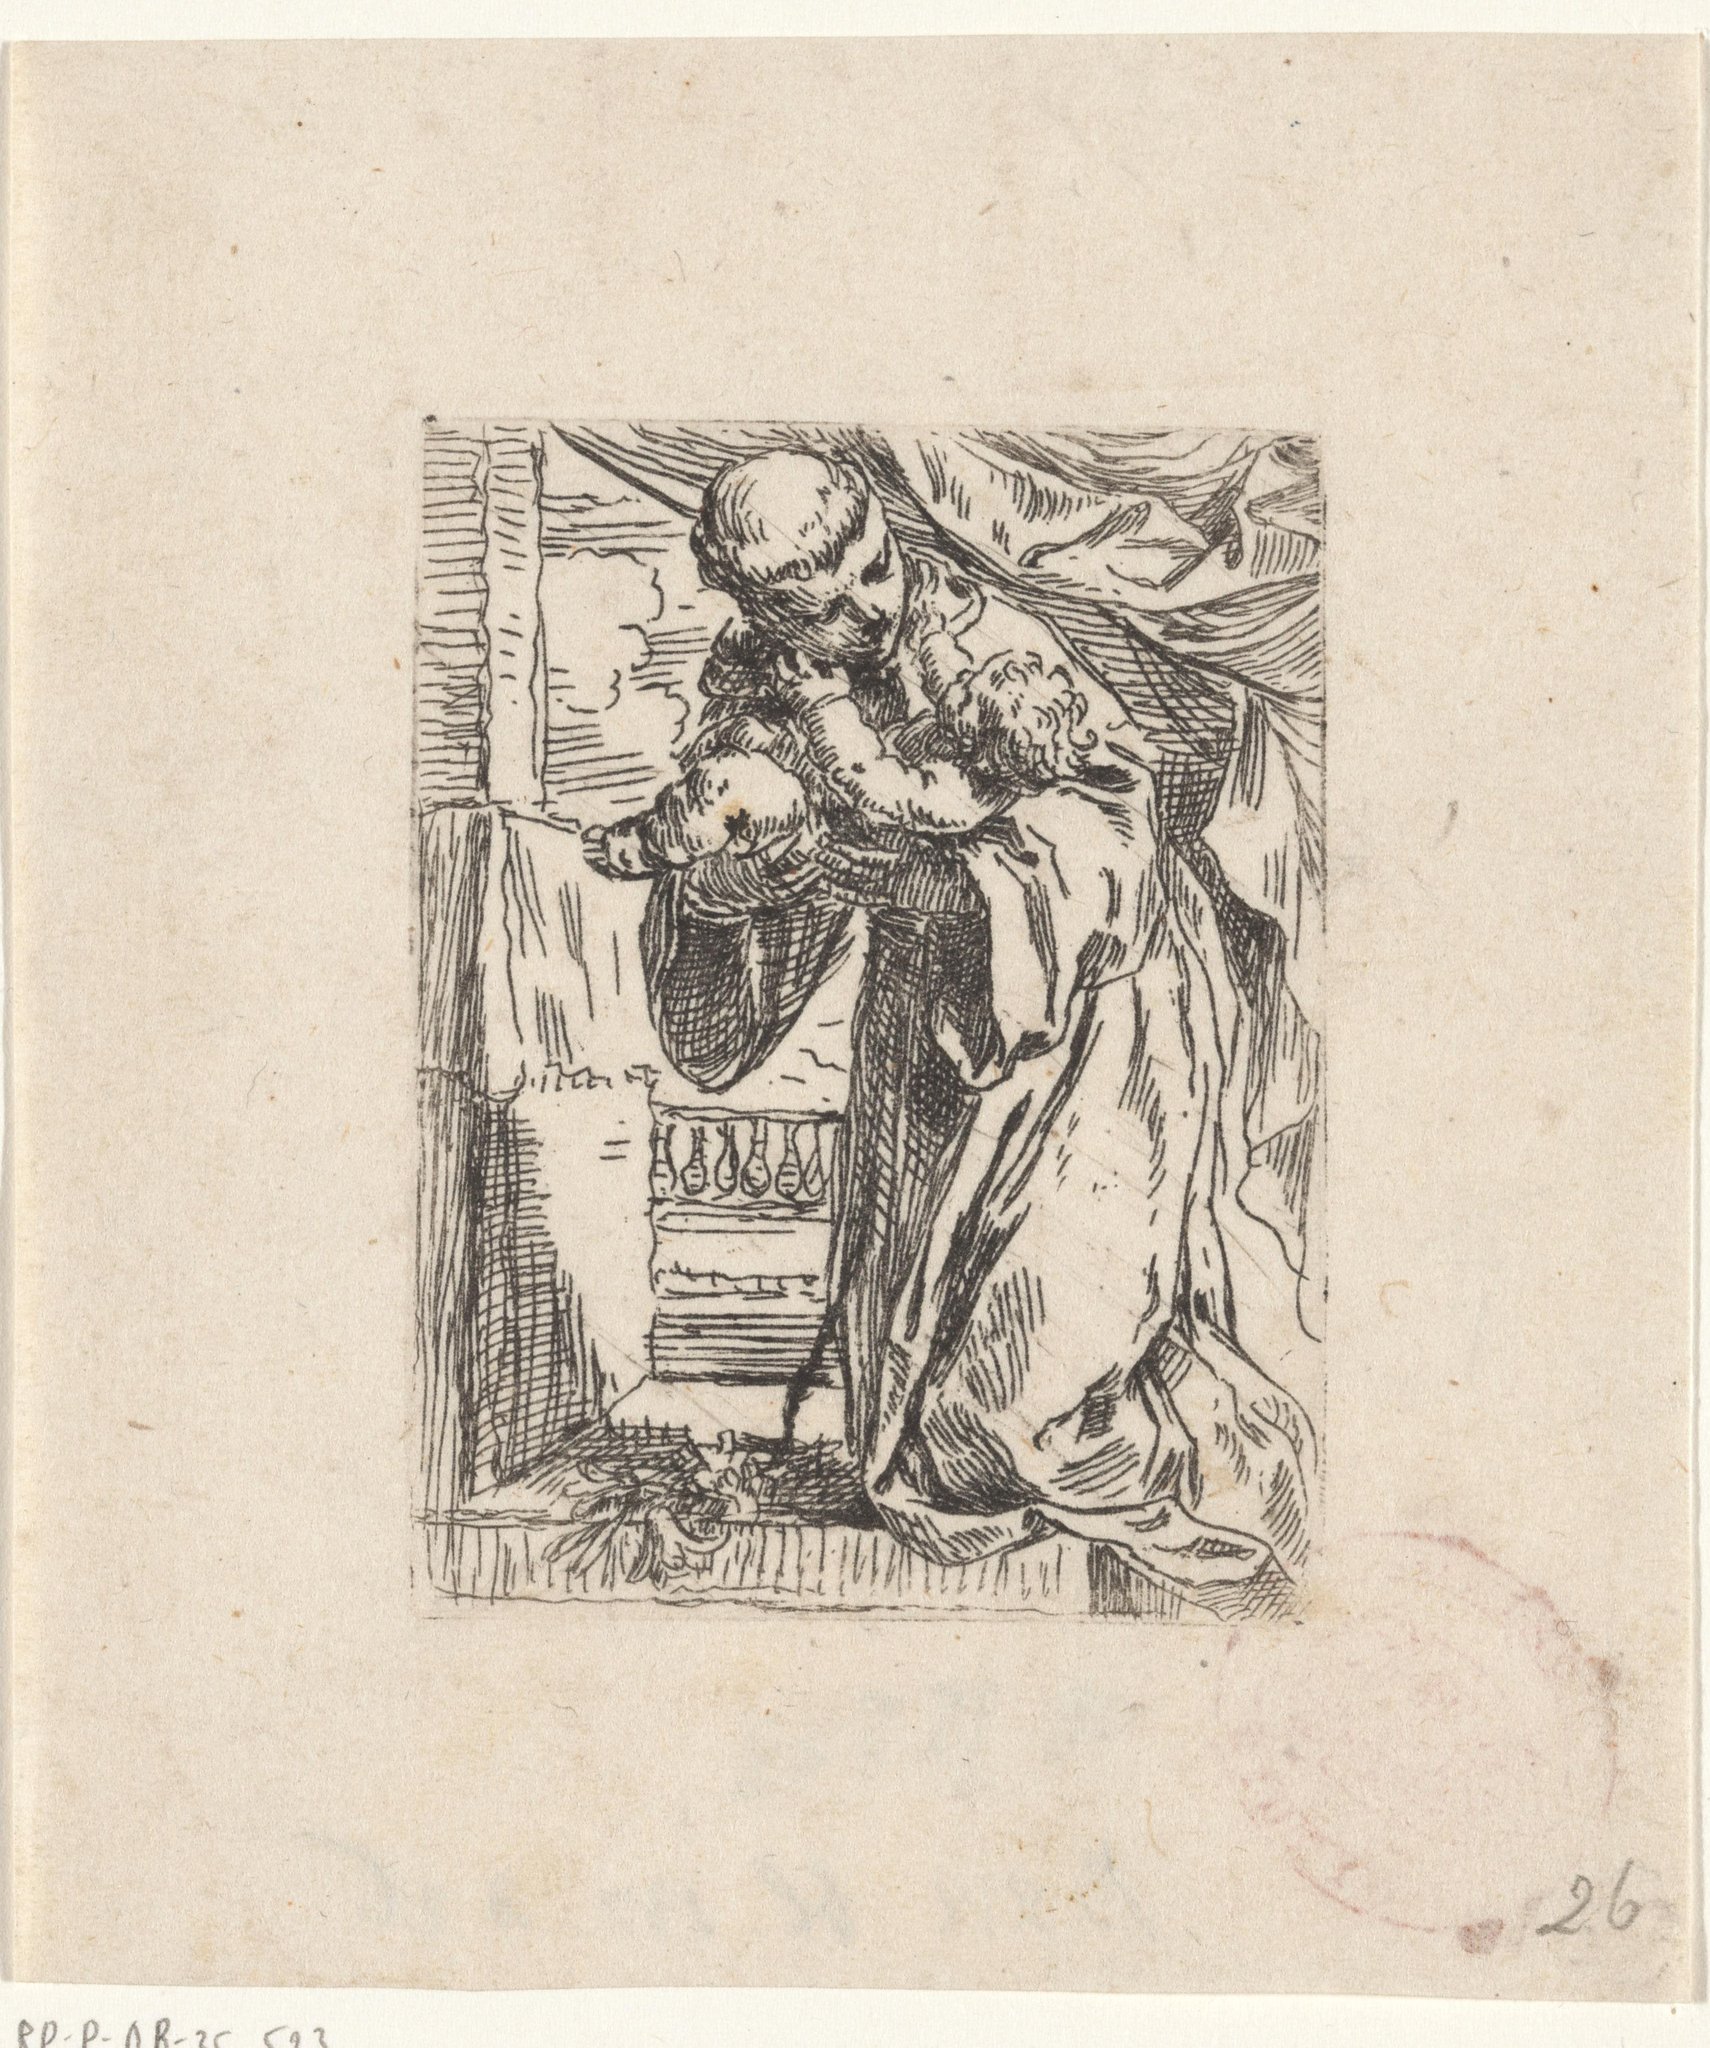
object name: print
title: Heilige Antonius van Padua met het Christuskind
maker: simone cantarini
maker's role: draughtsman, print maker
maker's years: 1612-1648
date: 1622-1648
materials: paper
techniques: printmaking, etching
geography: italy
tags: the franciscan monk antony of padua; possible attributes: ass, book, crucifix, flowered cross, flaming heart, infant christ (on book), lily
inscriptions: collector's mark: Lugt 240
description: De Heilige Antonius van Padua staat met het Christuskind in zijn armen voor een gordijn.